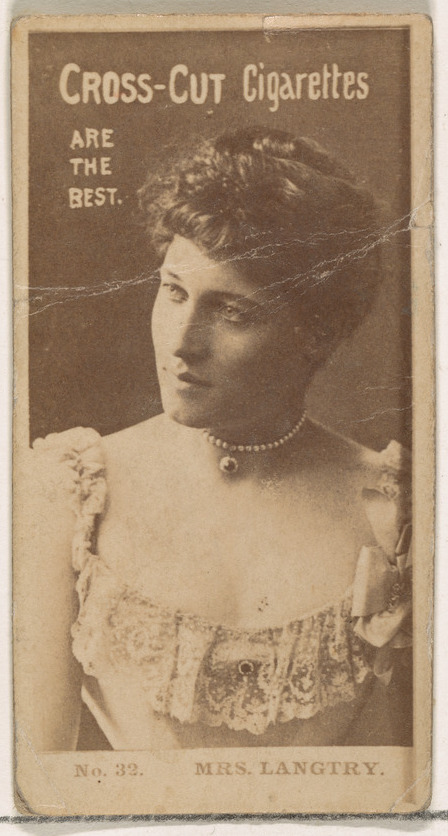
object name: print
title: Card Number 32, Mrs. Langtry, from the Actors and Actresses series (N145-2) issued by Duke Sons & Co. to promote Cross Cut Cigarettes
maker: w. duke, sons & co.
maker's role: publisher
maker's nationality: american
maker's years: 1870-1920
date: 1880-1889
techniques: albumen silver print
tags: portraits,women,actresses